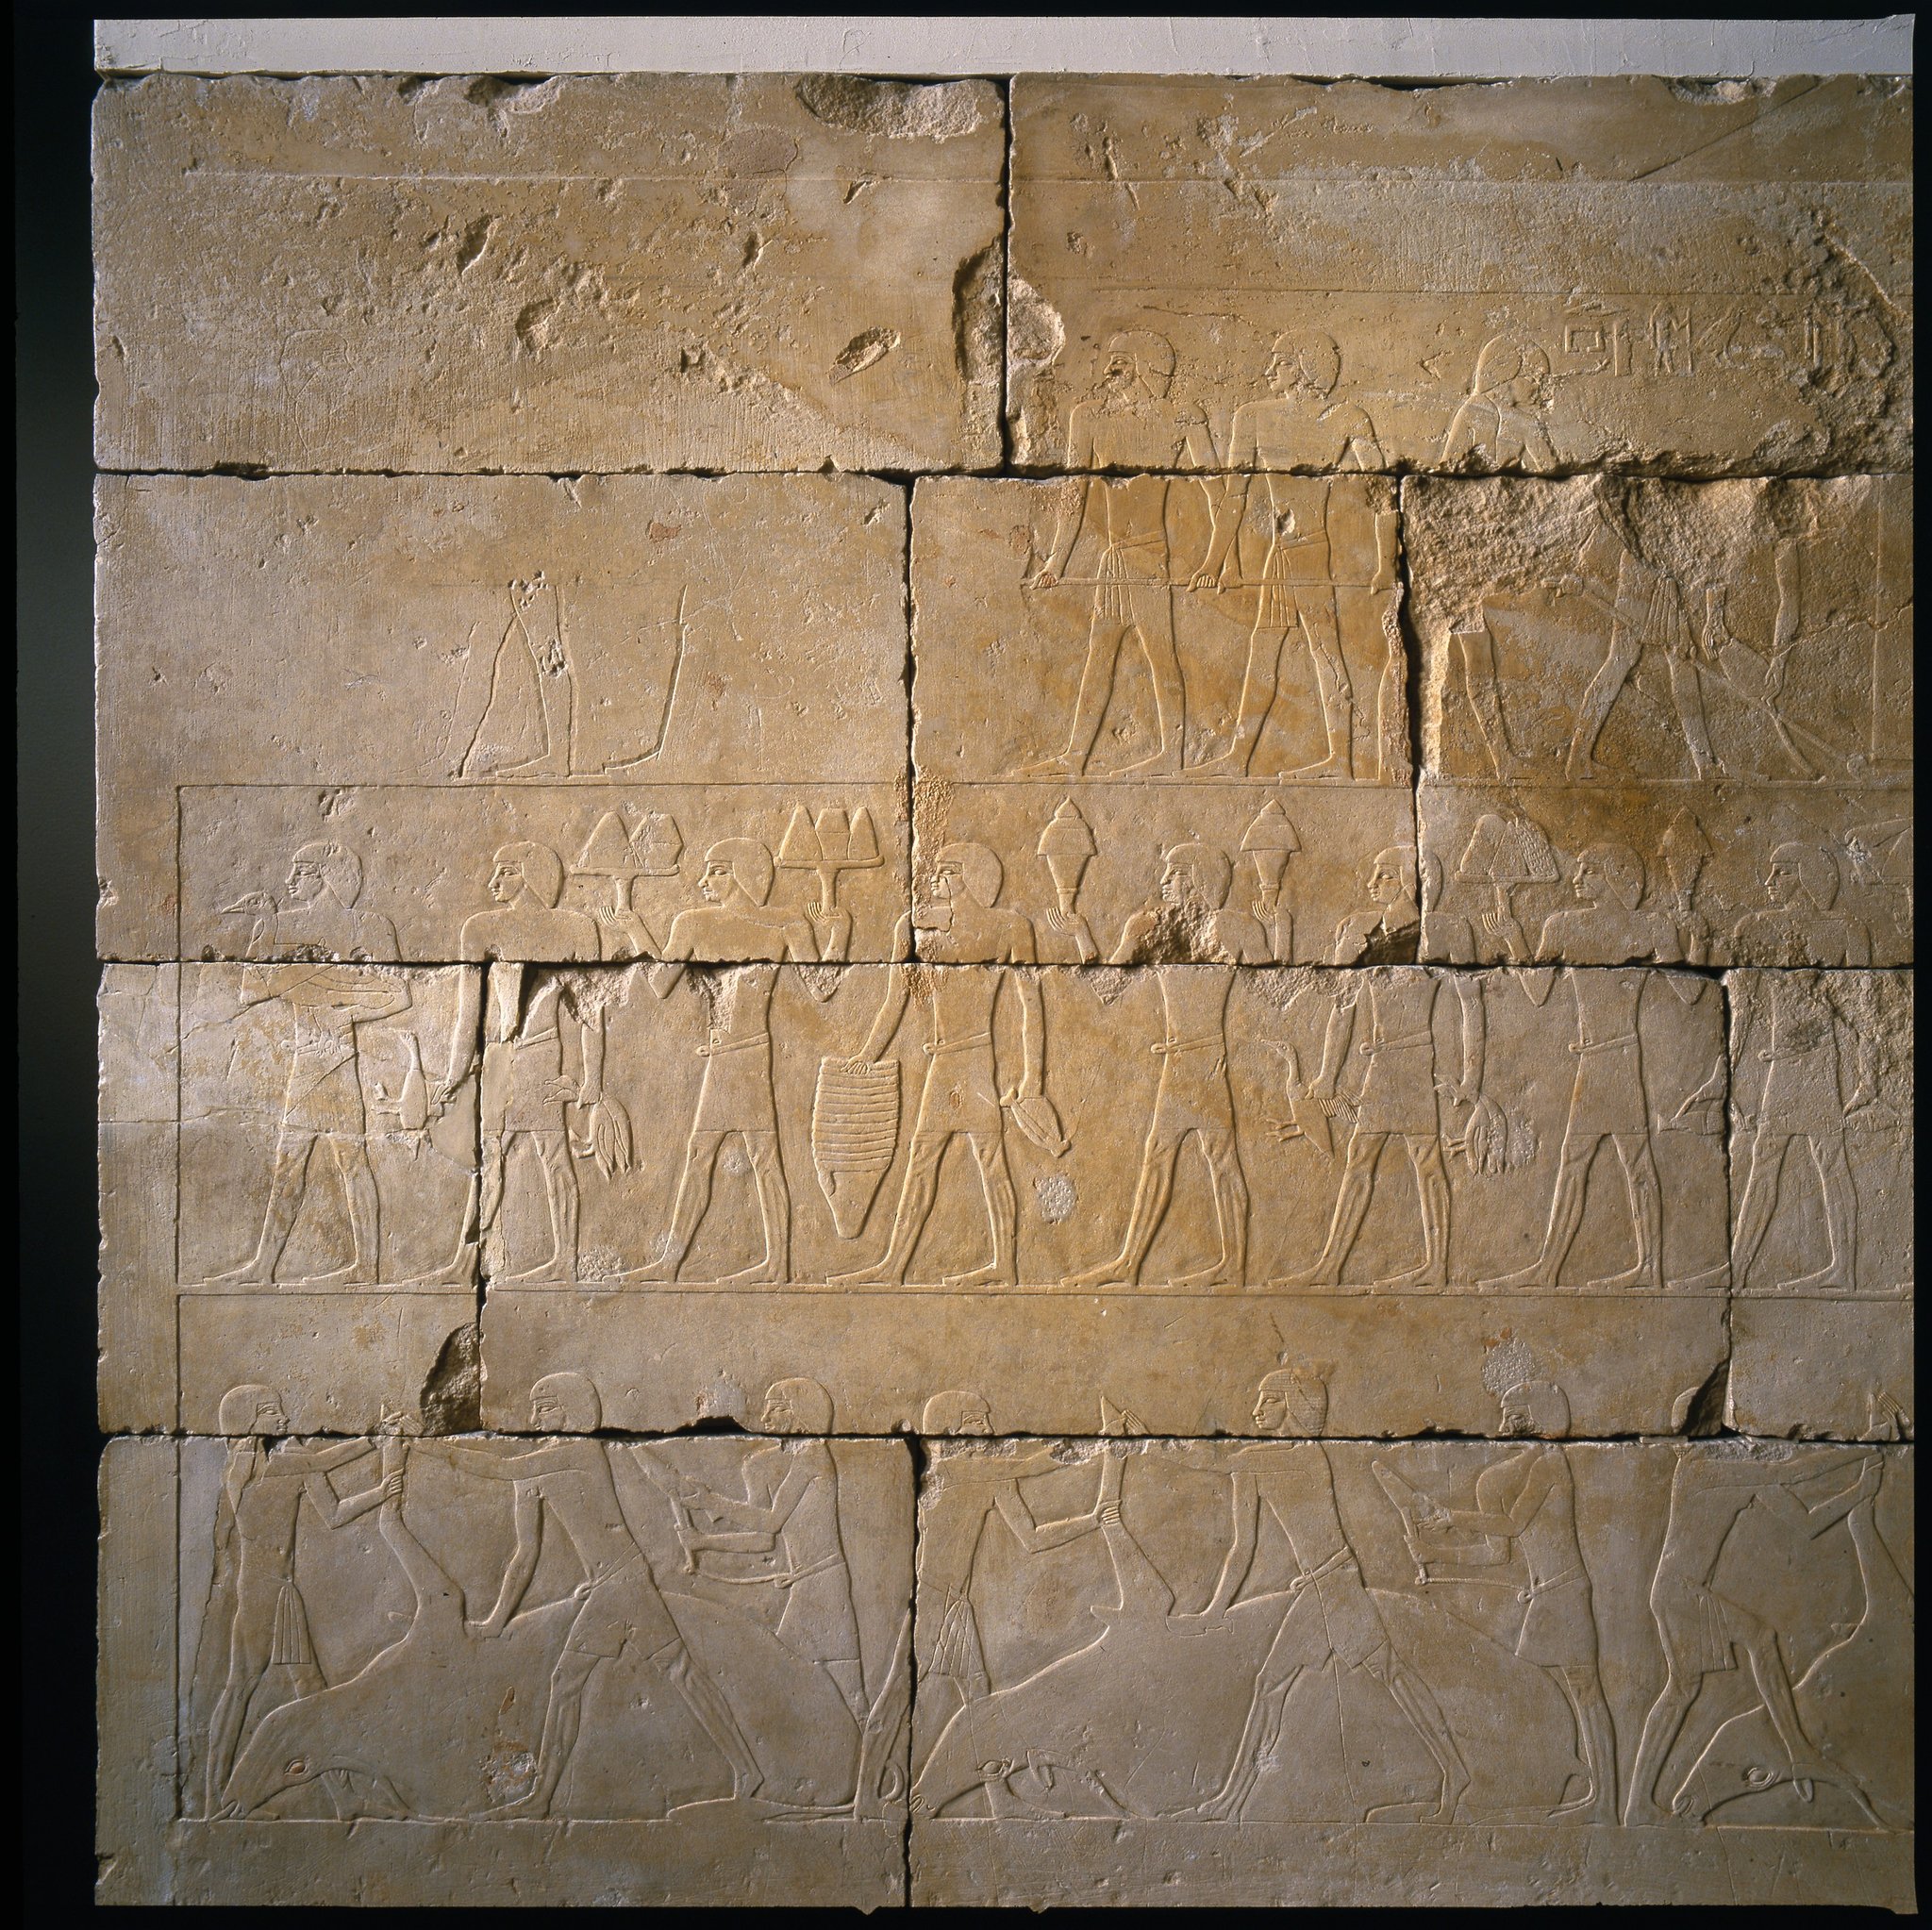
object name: relief, tomb chapel, raemkai, offering bearer, statue, slaughtering cattle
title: Tomb chapel of Raemkai: North wall of the entrance corridor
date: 2446-2389 BCE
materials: limestone, paint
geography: egypt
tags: animals,birds,men